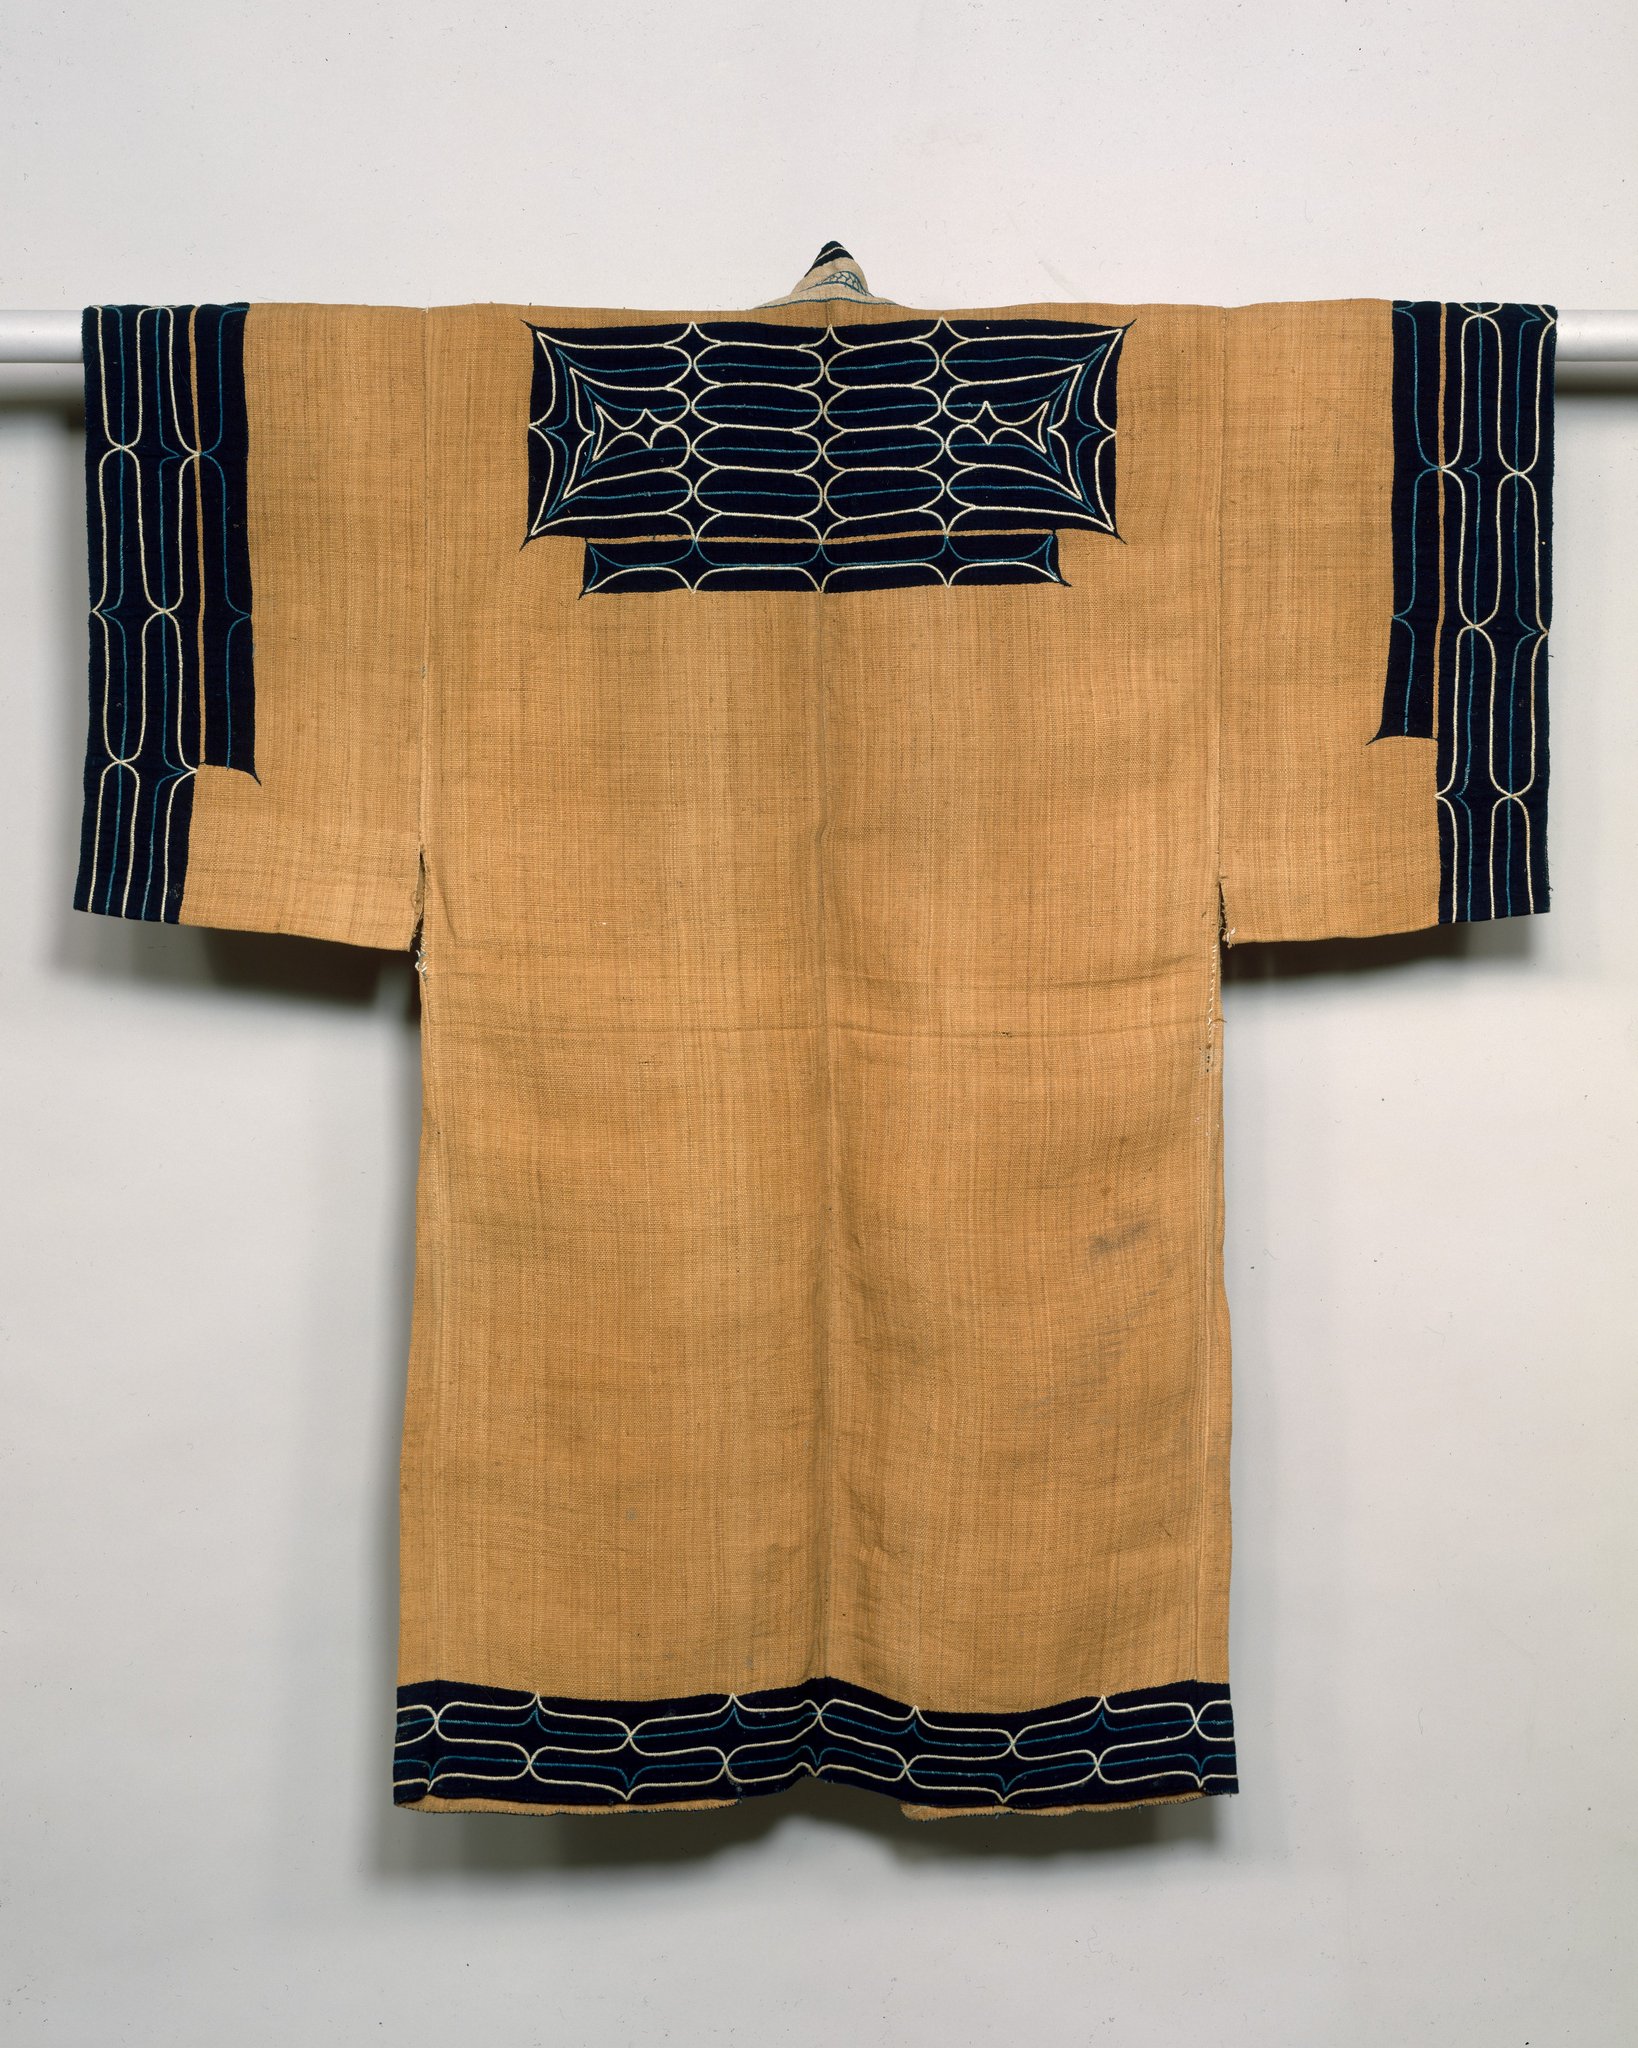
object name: ainu costume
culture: japanese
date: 1801-1900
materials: wood, fiber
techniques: appliqué, dyeing